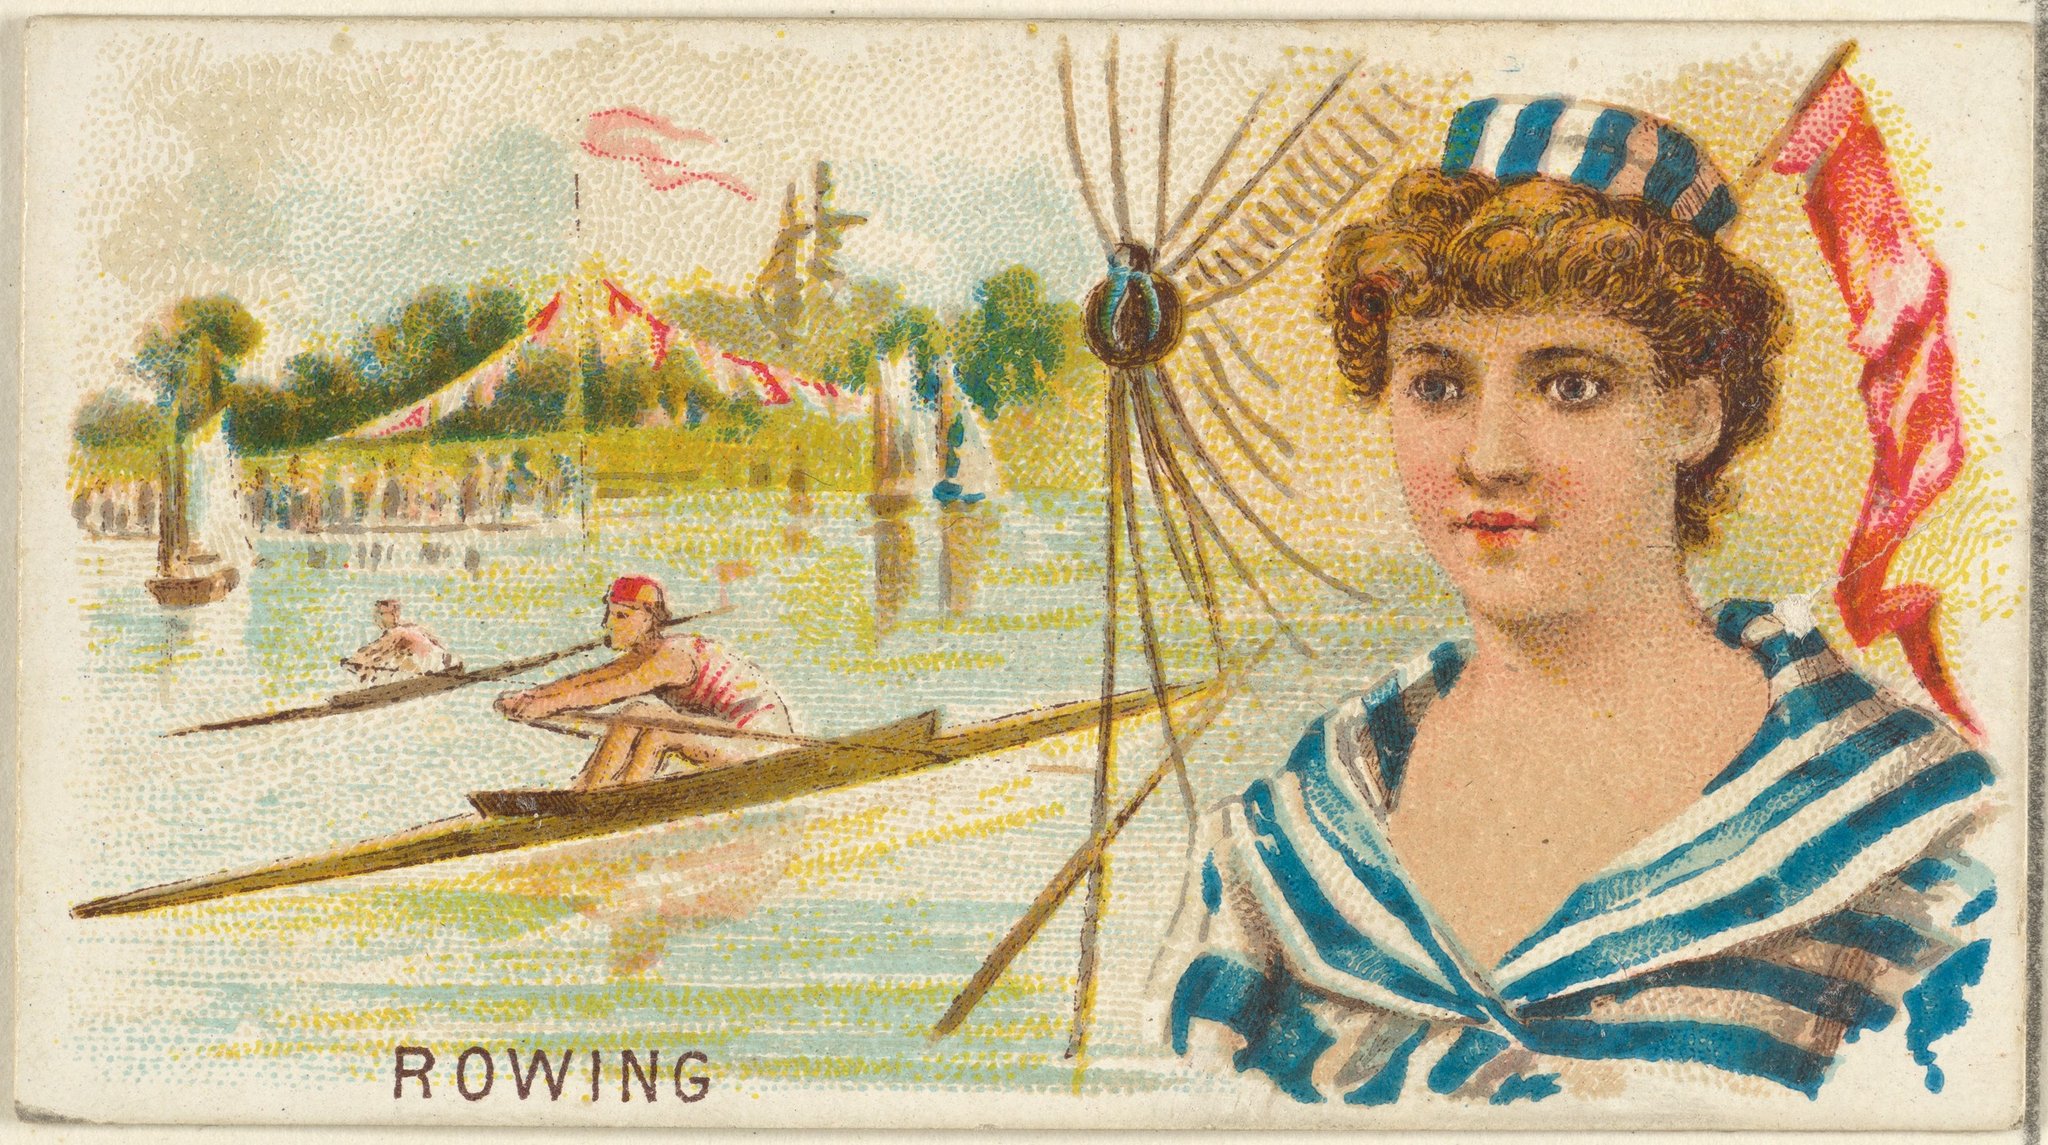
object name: print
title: Rowing, from the Games and Sports series (N165) for Old Judge Cigarettes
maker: goodwin & company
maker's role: publisher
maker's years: 1850-1950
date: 1889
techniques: color lithograph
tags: women,rowing,athletes